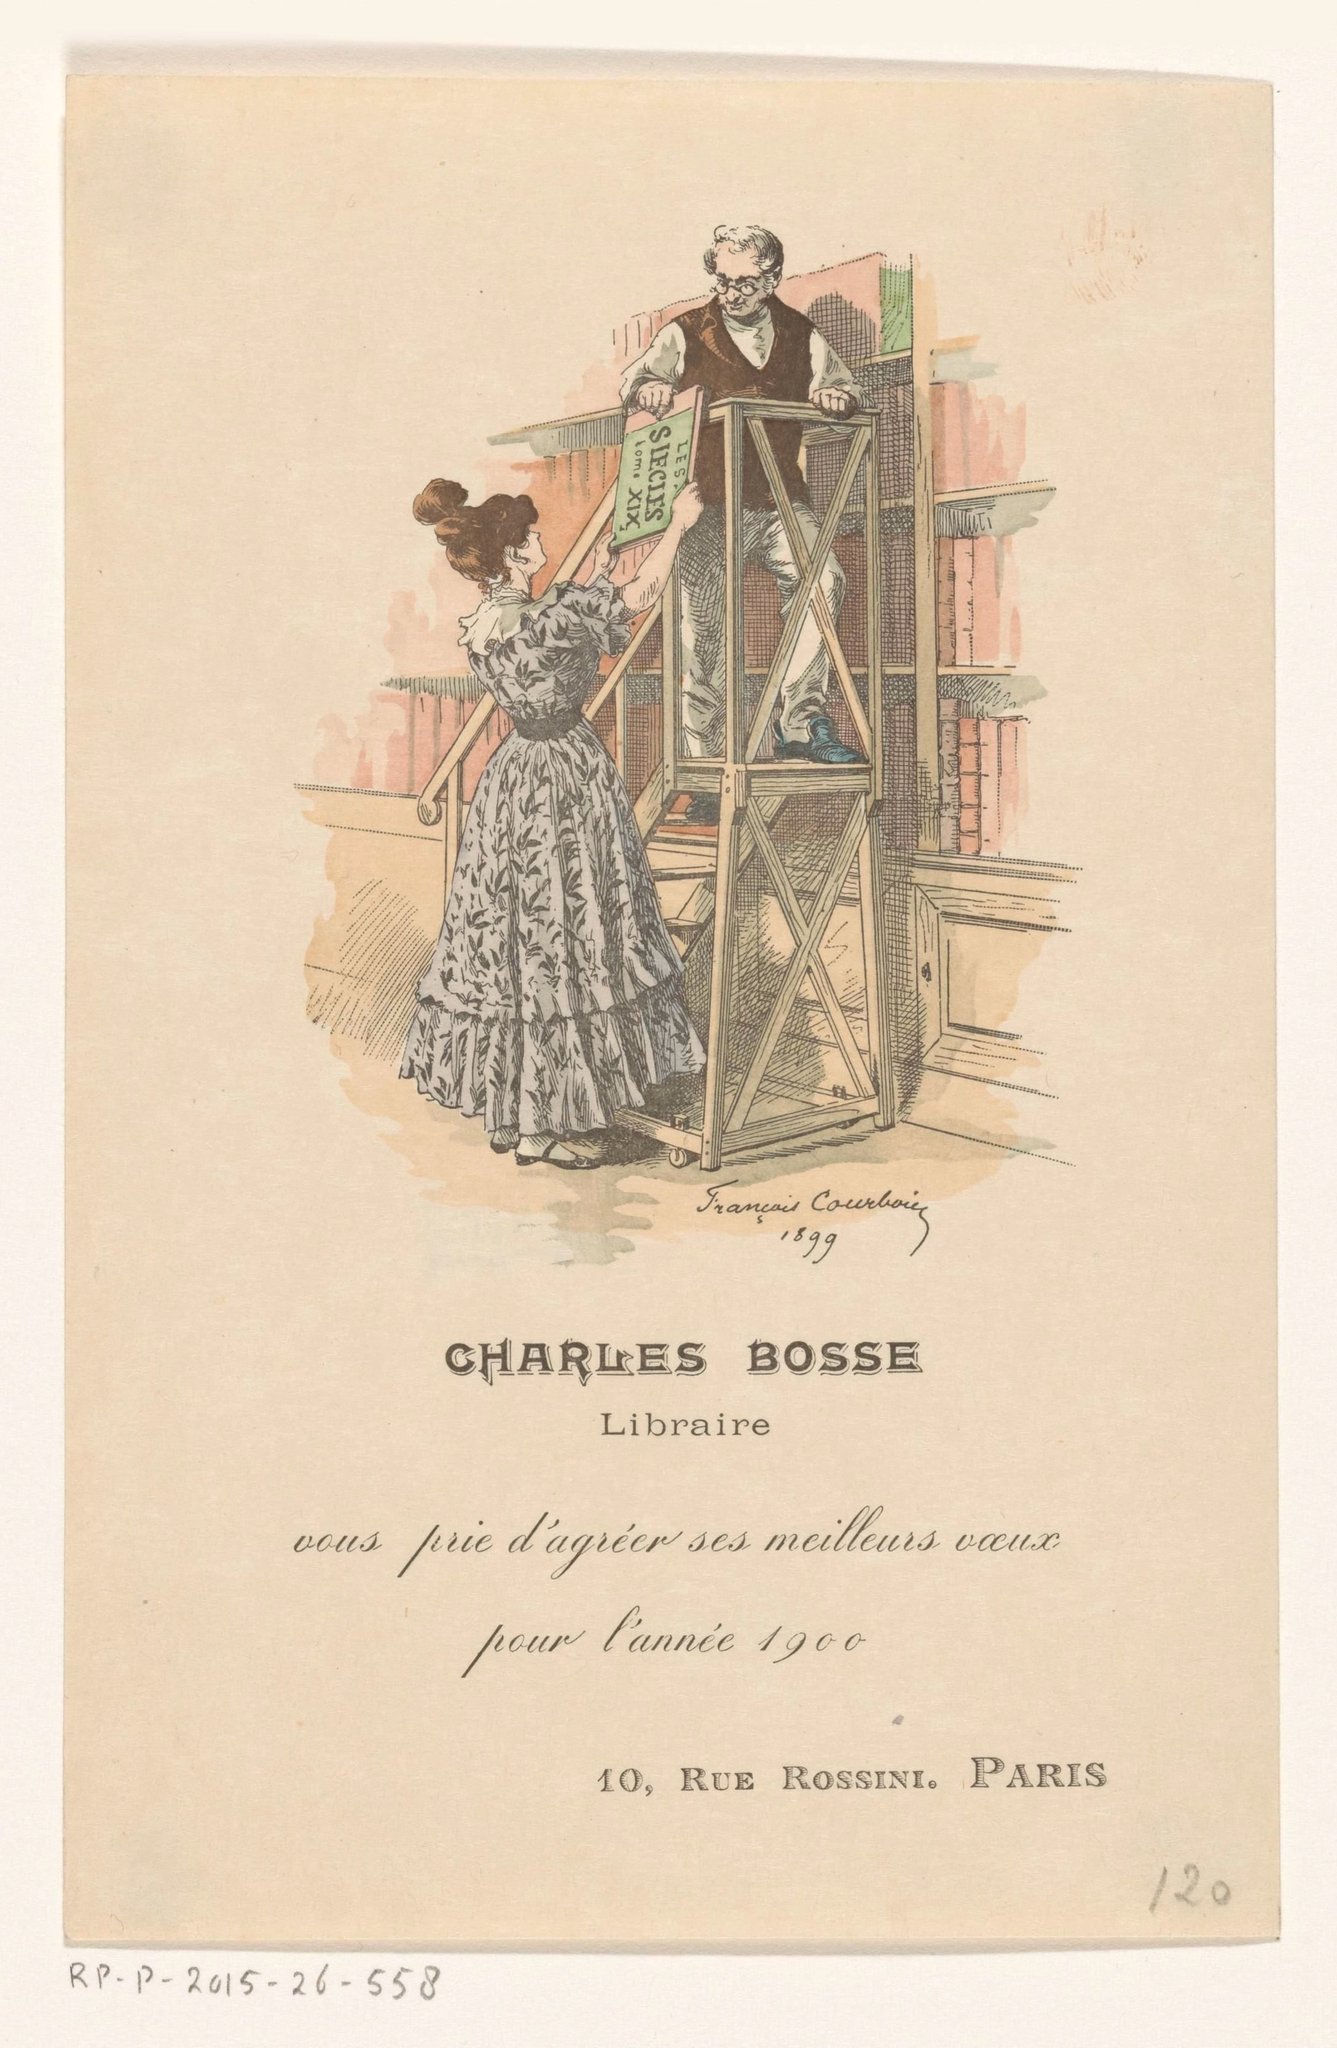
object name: new year card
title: Nieuwjaarswens van boekhandelaar Charles Bosse te Parijs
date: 1899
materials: paper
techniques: hand coloring, letterpress printing, engraving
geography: paris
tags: bookshelves, book, book-shop, bookseller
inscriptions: collector's mark: Lugt 4779, collector's mark: Lugt 2228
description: Een vrouw overhandigt een boek aan een man die op een bibliotheektrapje voor een boekenkast staat.